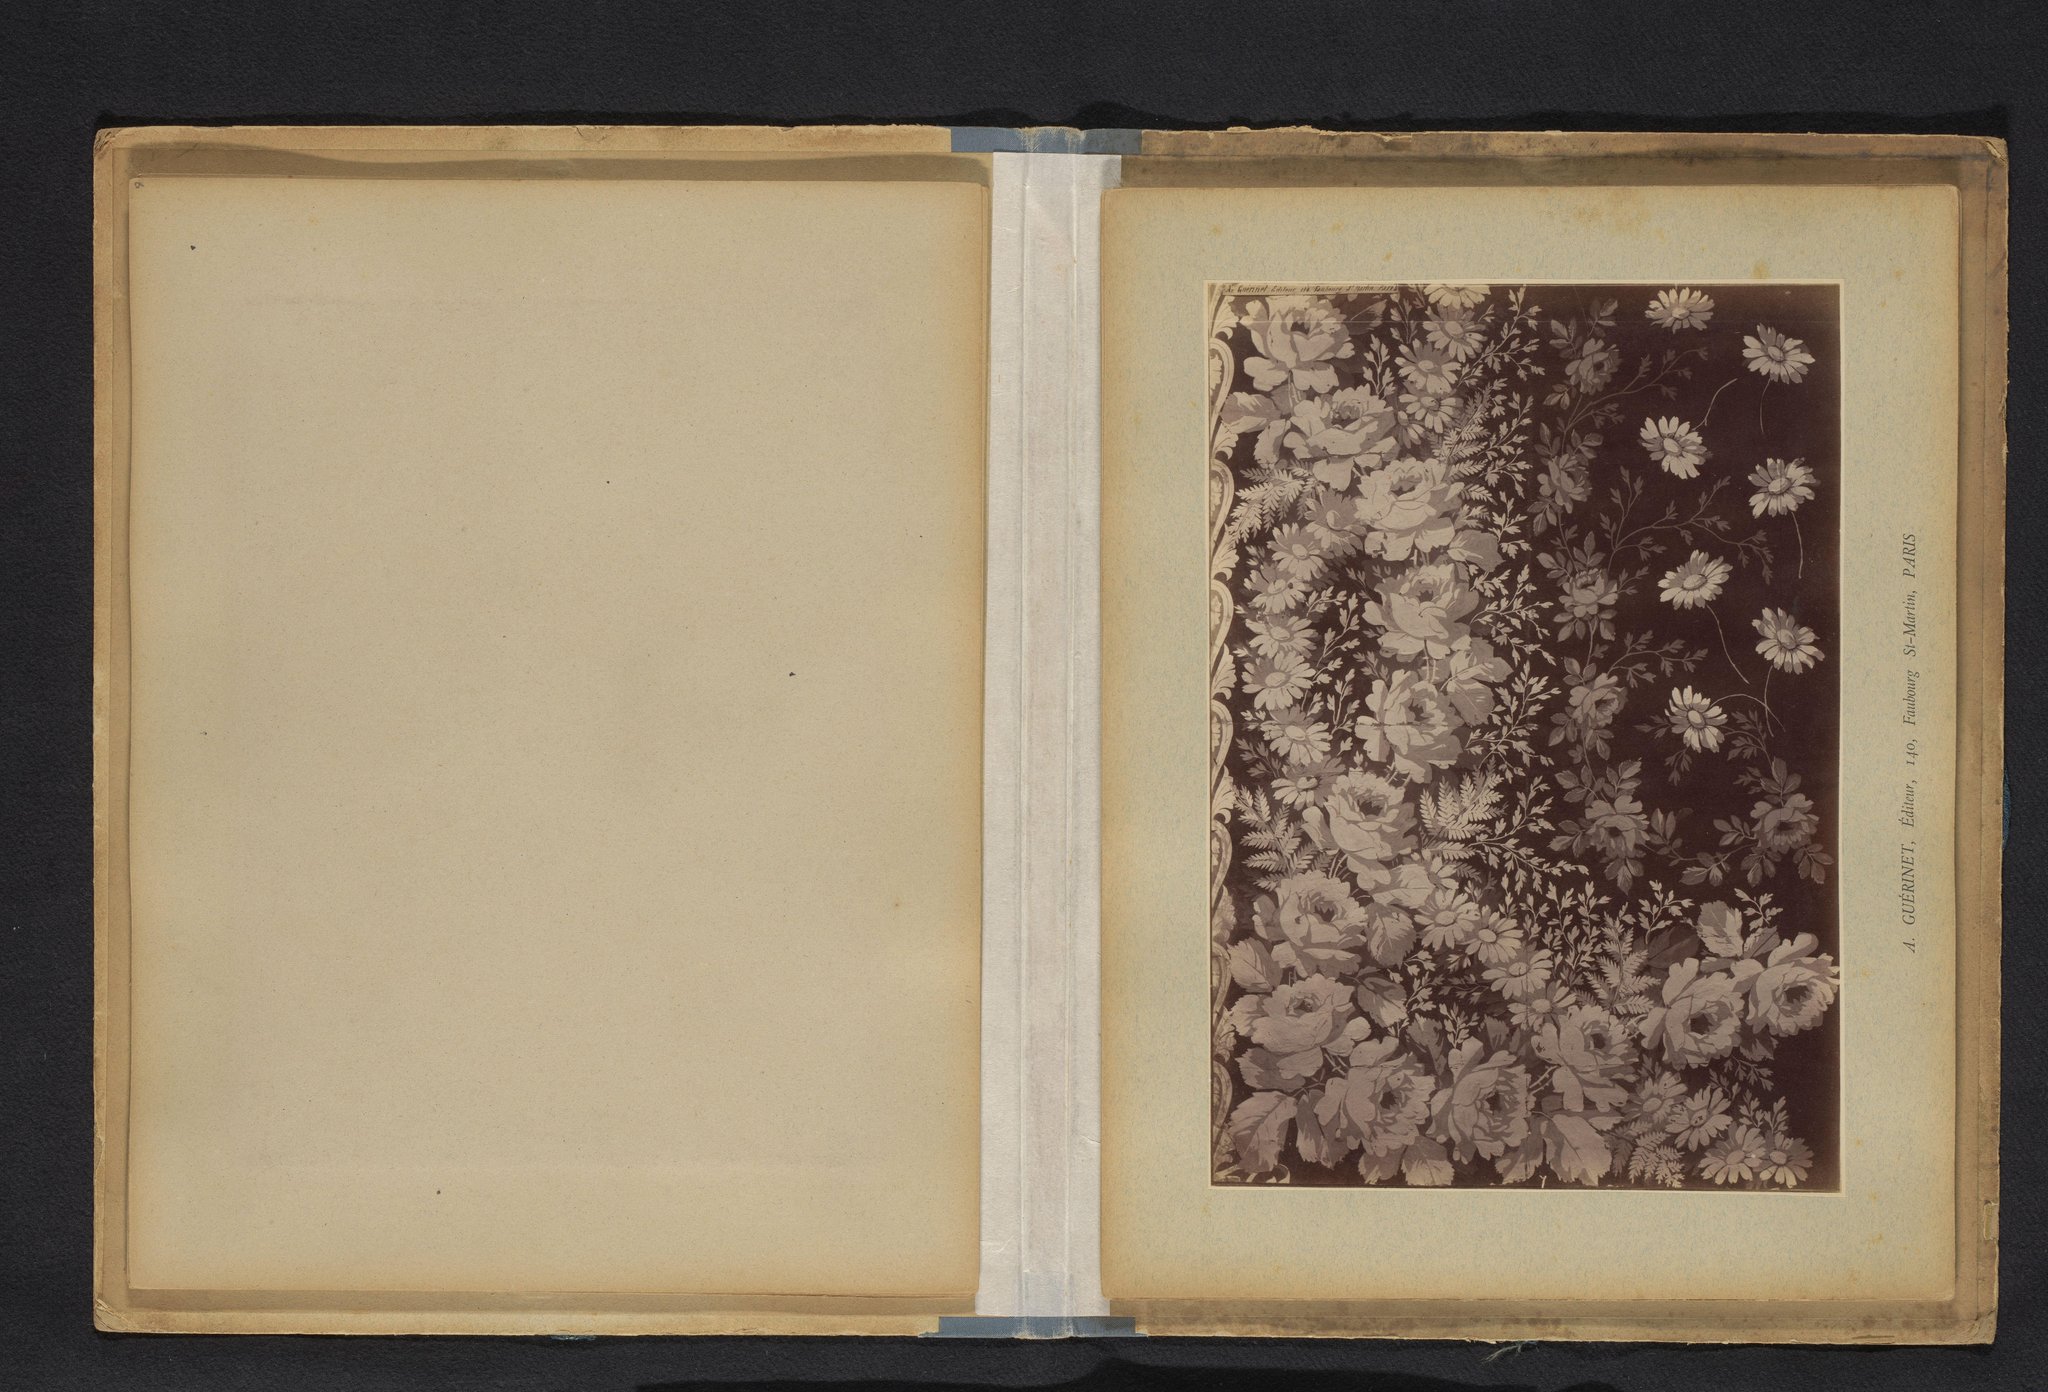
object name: photograph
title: Fotoreproductie van een decoratief bloemenpatroon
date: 1890-1900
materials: photographic support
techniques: albumen print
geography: paris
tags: flowers ~ ornament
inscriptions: number: ‘7’